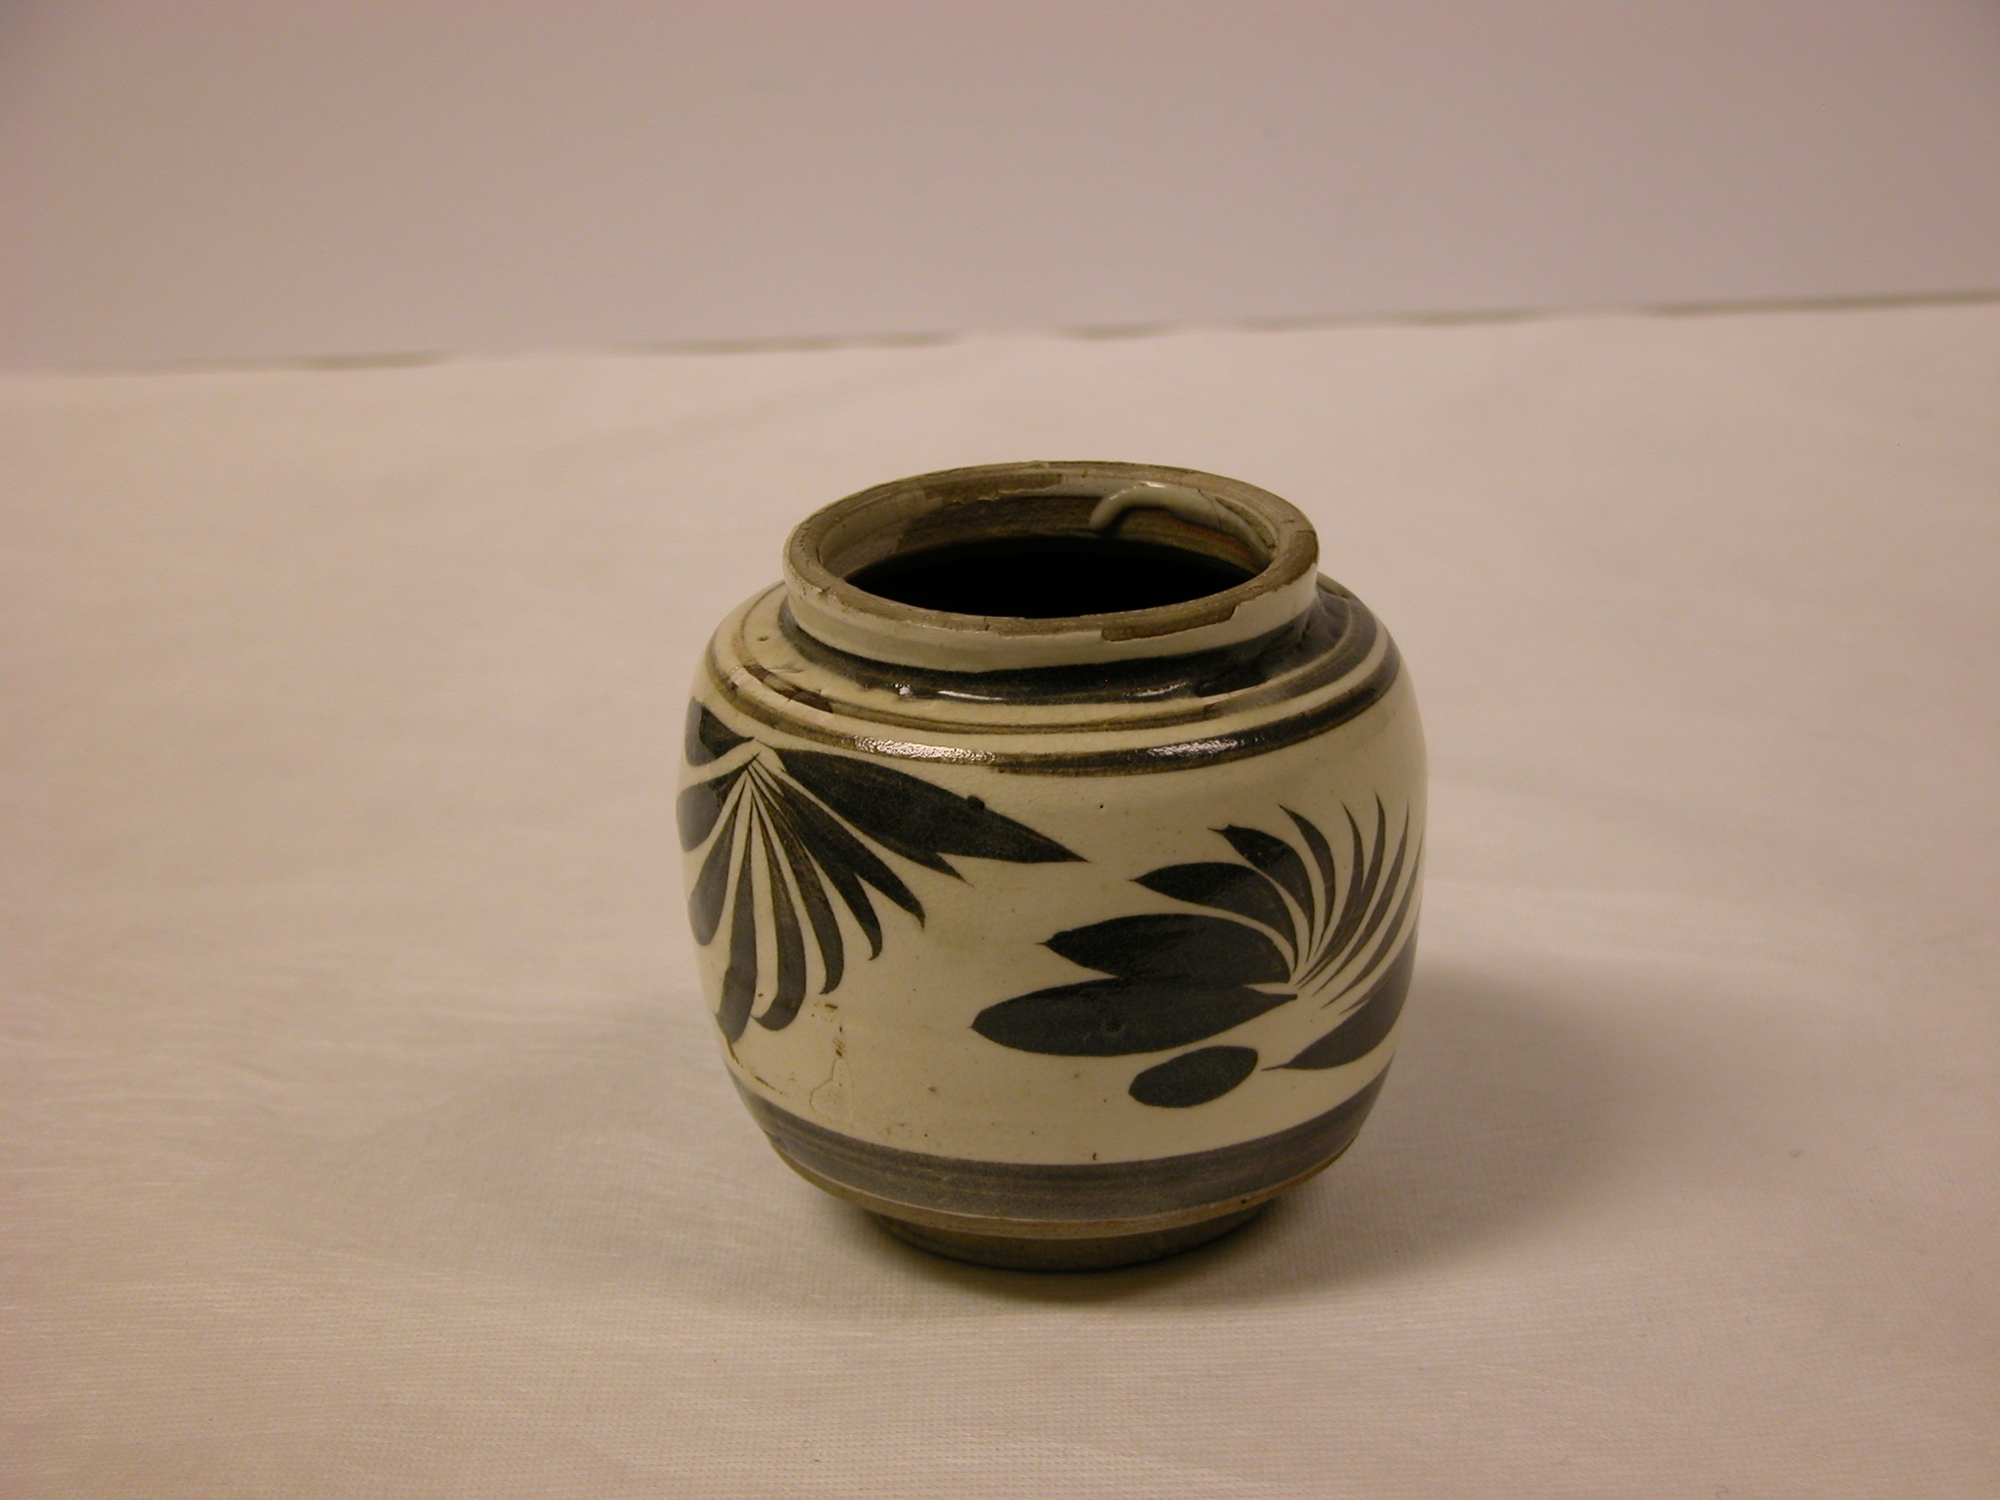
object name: jar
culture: chinese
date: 969-1279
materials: pottery